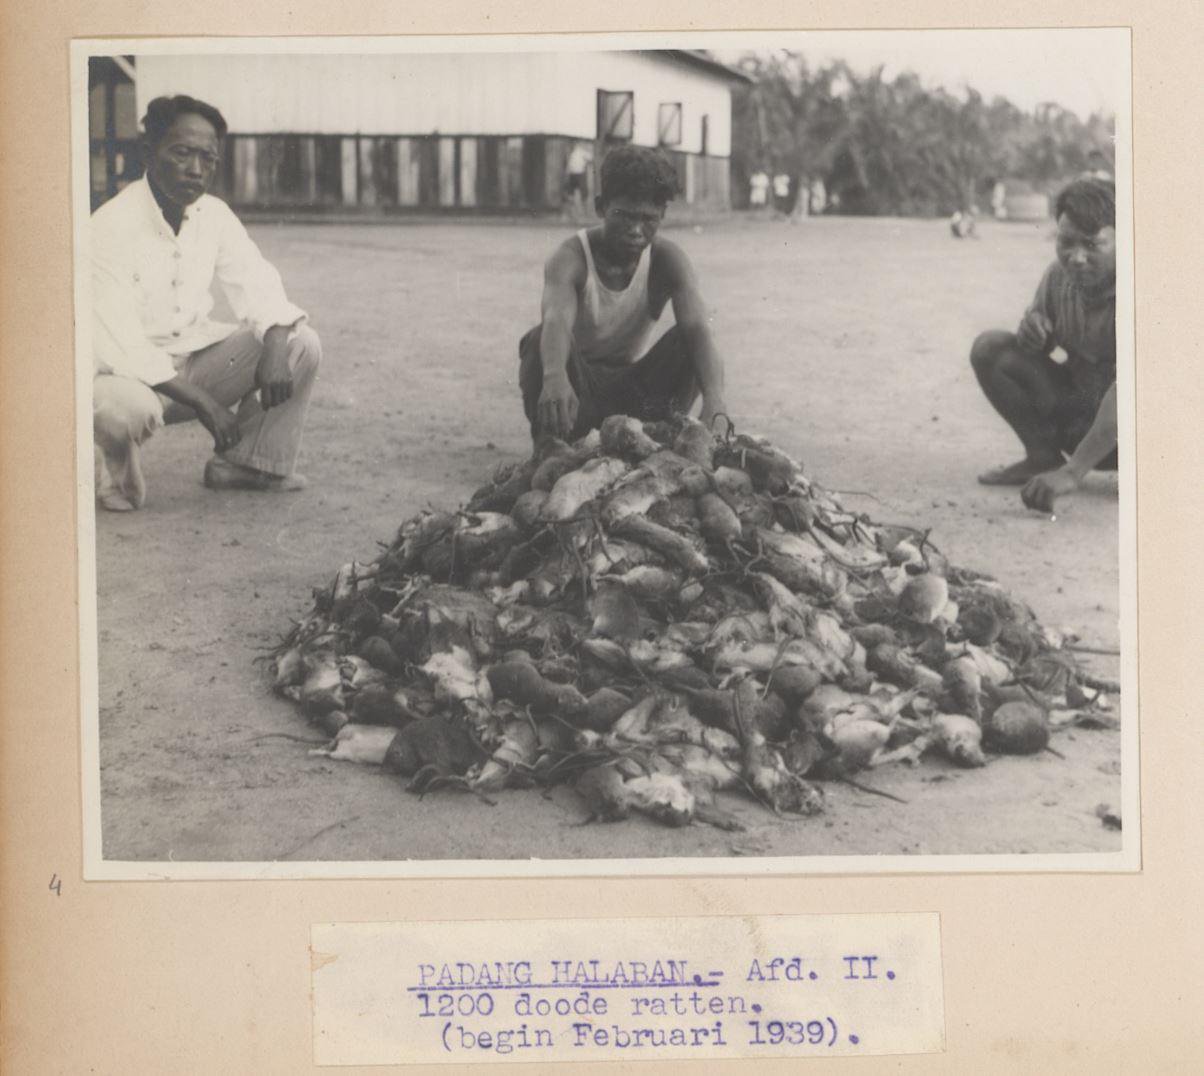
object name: photograph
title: Padang Halaban - Afd. II. 1200 doode ratten. (begin Februari 1939)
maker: Anonymous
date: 1902-1939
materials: photographic support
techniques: gelatin silver print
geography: sumatra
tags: extermination of rats, rodents: rat (+ dying animal; death of animal; dead animal), (non-fruit) products of plants or trees: palm oil, sumatra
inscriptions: inscription: ‘Padang Halaban - Afd. II. 1200 doode ratten. (begin Februari 1939)’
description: Drie mannen hurkend bij een stapel dode ratten, gevangen op de plantage Padang Halaban, februari 1939. Onderdeel van het fotoalbum over de plantages Pernantian en Brussel van de Sumatra Caoutchouc Maatschappij op de Oostkust van Sumatra in de jaren 1935-1939.